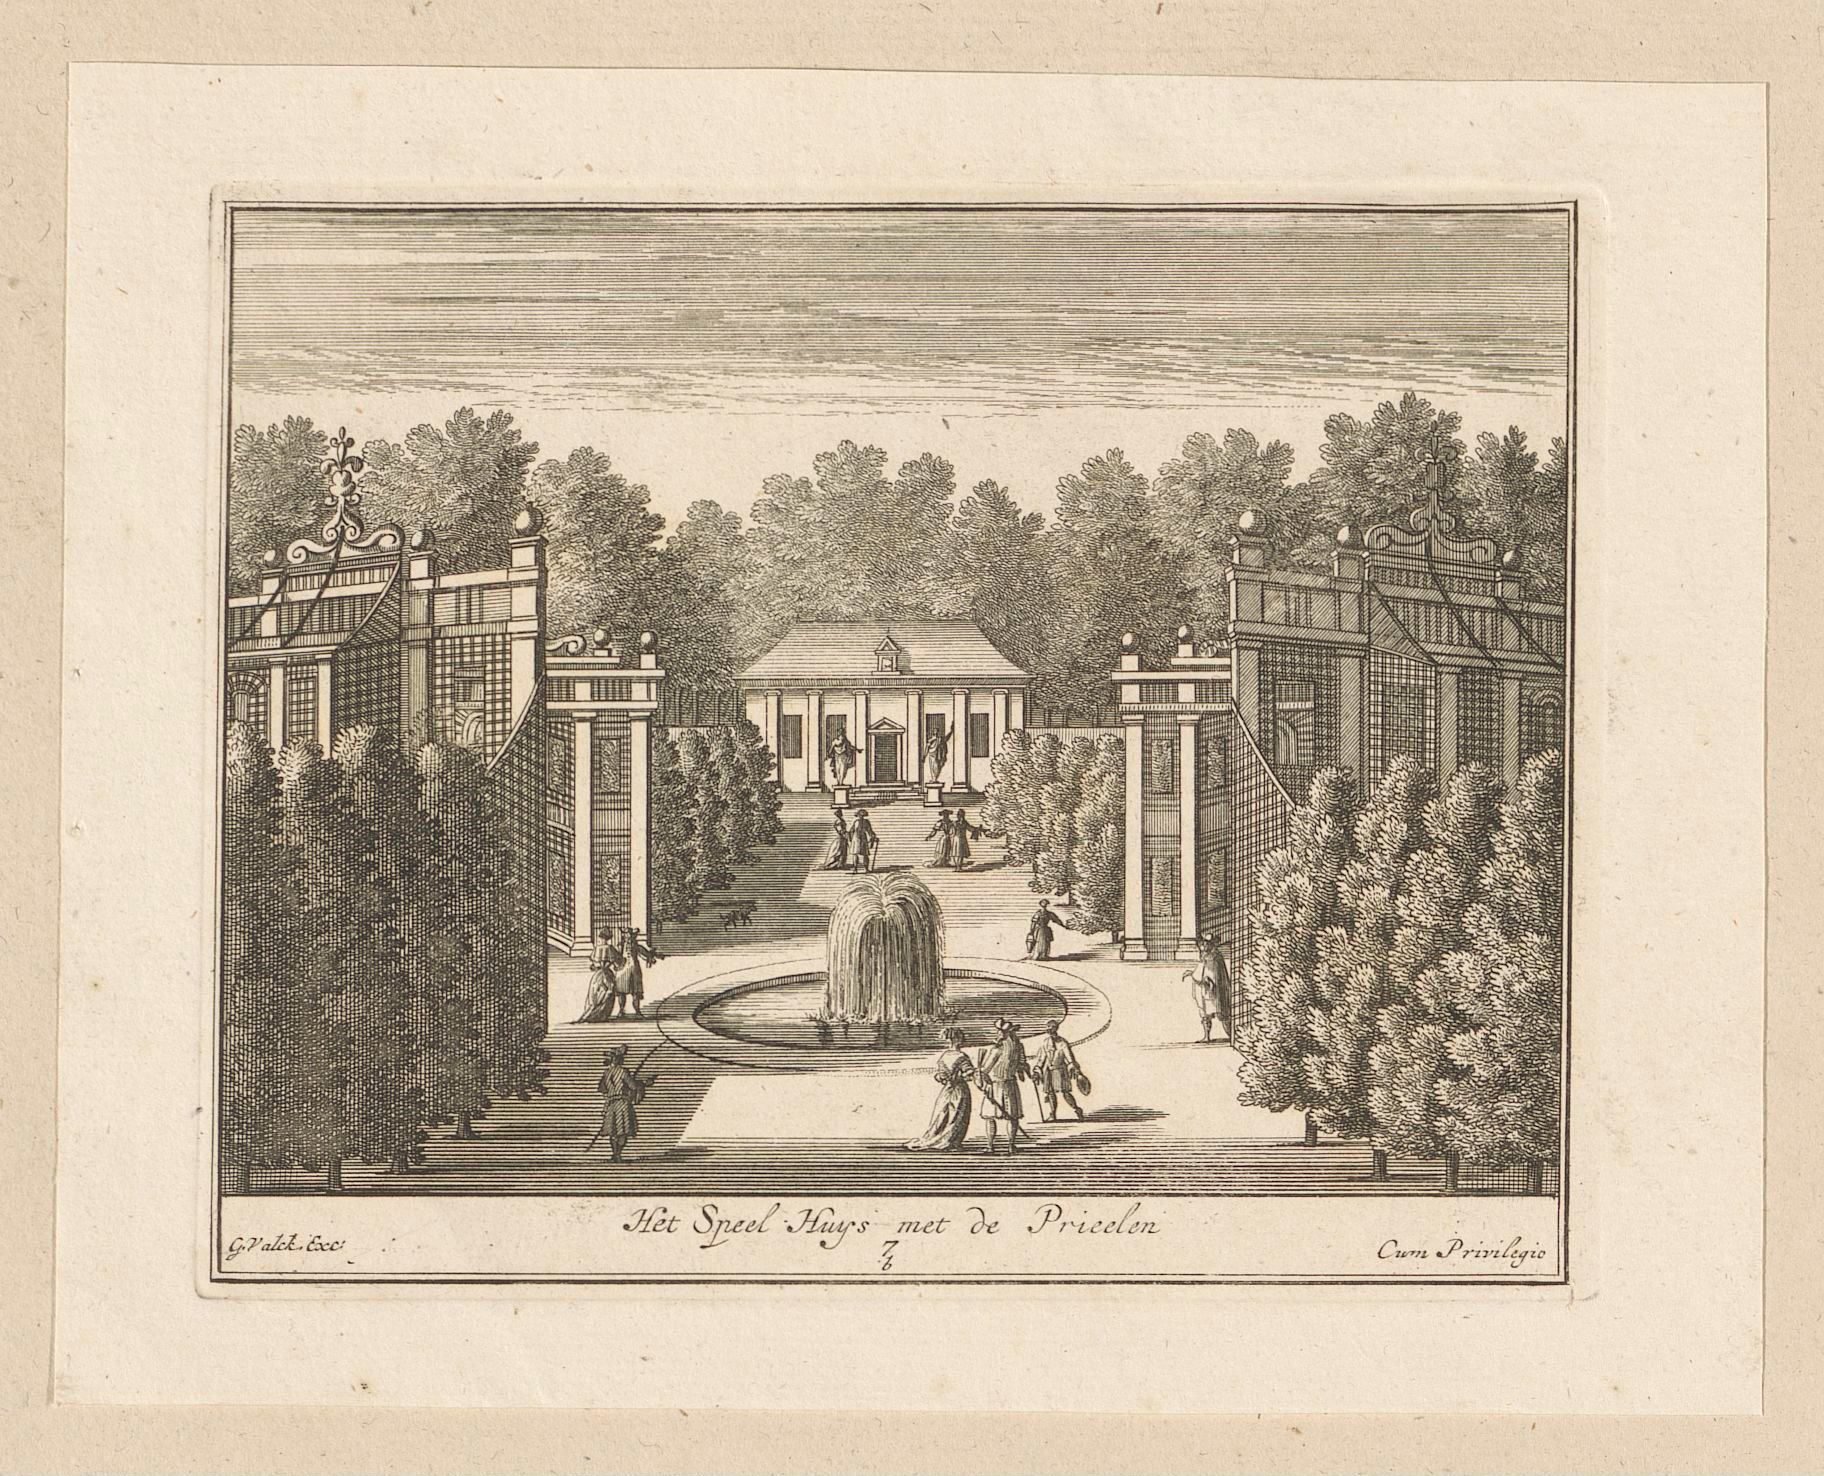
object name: print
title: Het speel huys met de prieelen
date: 1695-1757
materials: paper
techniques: engraving, etching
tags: palace, french or architectonic garden; formal garden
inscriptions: collector's mark: Lugt 2233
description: Onderdeel van een serie van zestien prenten van Paleis Honselaarsdijk, oorspronkelijk gemaakt (en waarschijnlijk ook uitgegeven) door Abraham Bloteling rond 1684. Op de eerste staat van de prenten stond zijn naam linksonder, de sporen hiervan zijn met name op de negende prent (RP-P-AO-11-80-9B) nog duidelijk te zien. Deze staat van de serie is zeldzaam, mogelijk bezit de Bibliothèque Nationale een exemplaar. Zijn schoonbroer Gerard Valck heeft de reeks vervolgens in 1695 uitgegeven samen met drie andere prentseries onder de titel 'Veues et perspectives de Loo, Honslardyck et Soesdyck, chasteaux & maisons de plaisance du Roy de la Grande Bretagne, ausquels on a adjoûté les veuës des environs de Cleves', met voor de prenten van Honselaarsdijk de subtitel 'Veues et perspectives de Honslardyck, chasteau et maison de plaisance du Roy de la Grande Bretagne, le tout dessiné & gravé par les plus habiles maistres'. Valck heeft de platen aangepast waardoor van elke prent een tweede staat ontstond. Vervolgens zijn de platen in handen van Isaac Greve gekomen, die de serie nog een keer uitgaf onder de titel '16. gesigte van 't koninglyke lust huys Honslardyk'. Vermoedelijk heeft Greve alleen de plaat van de eerste prent bijgewerkt en de rest onveranderd gelaten waardoor van de eerste prent drie staten bekend zijn en van de rest twee.